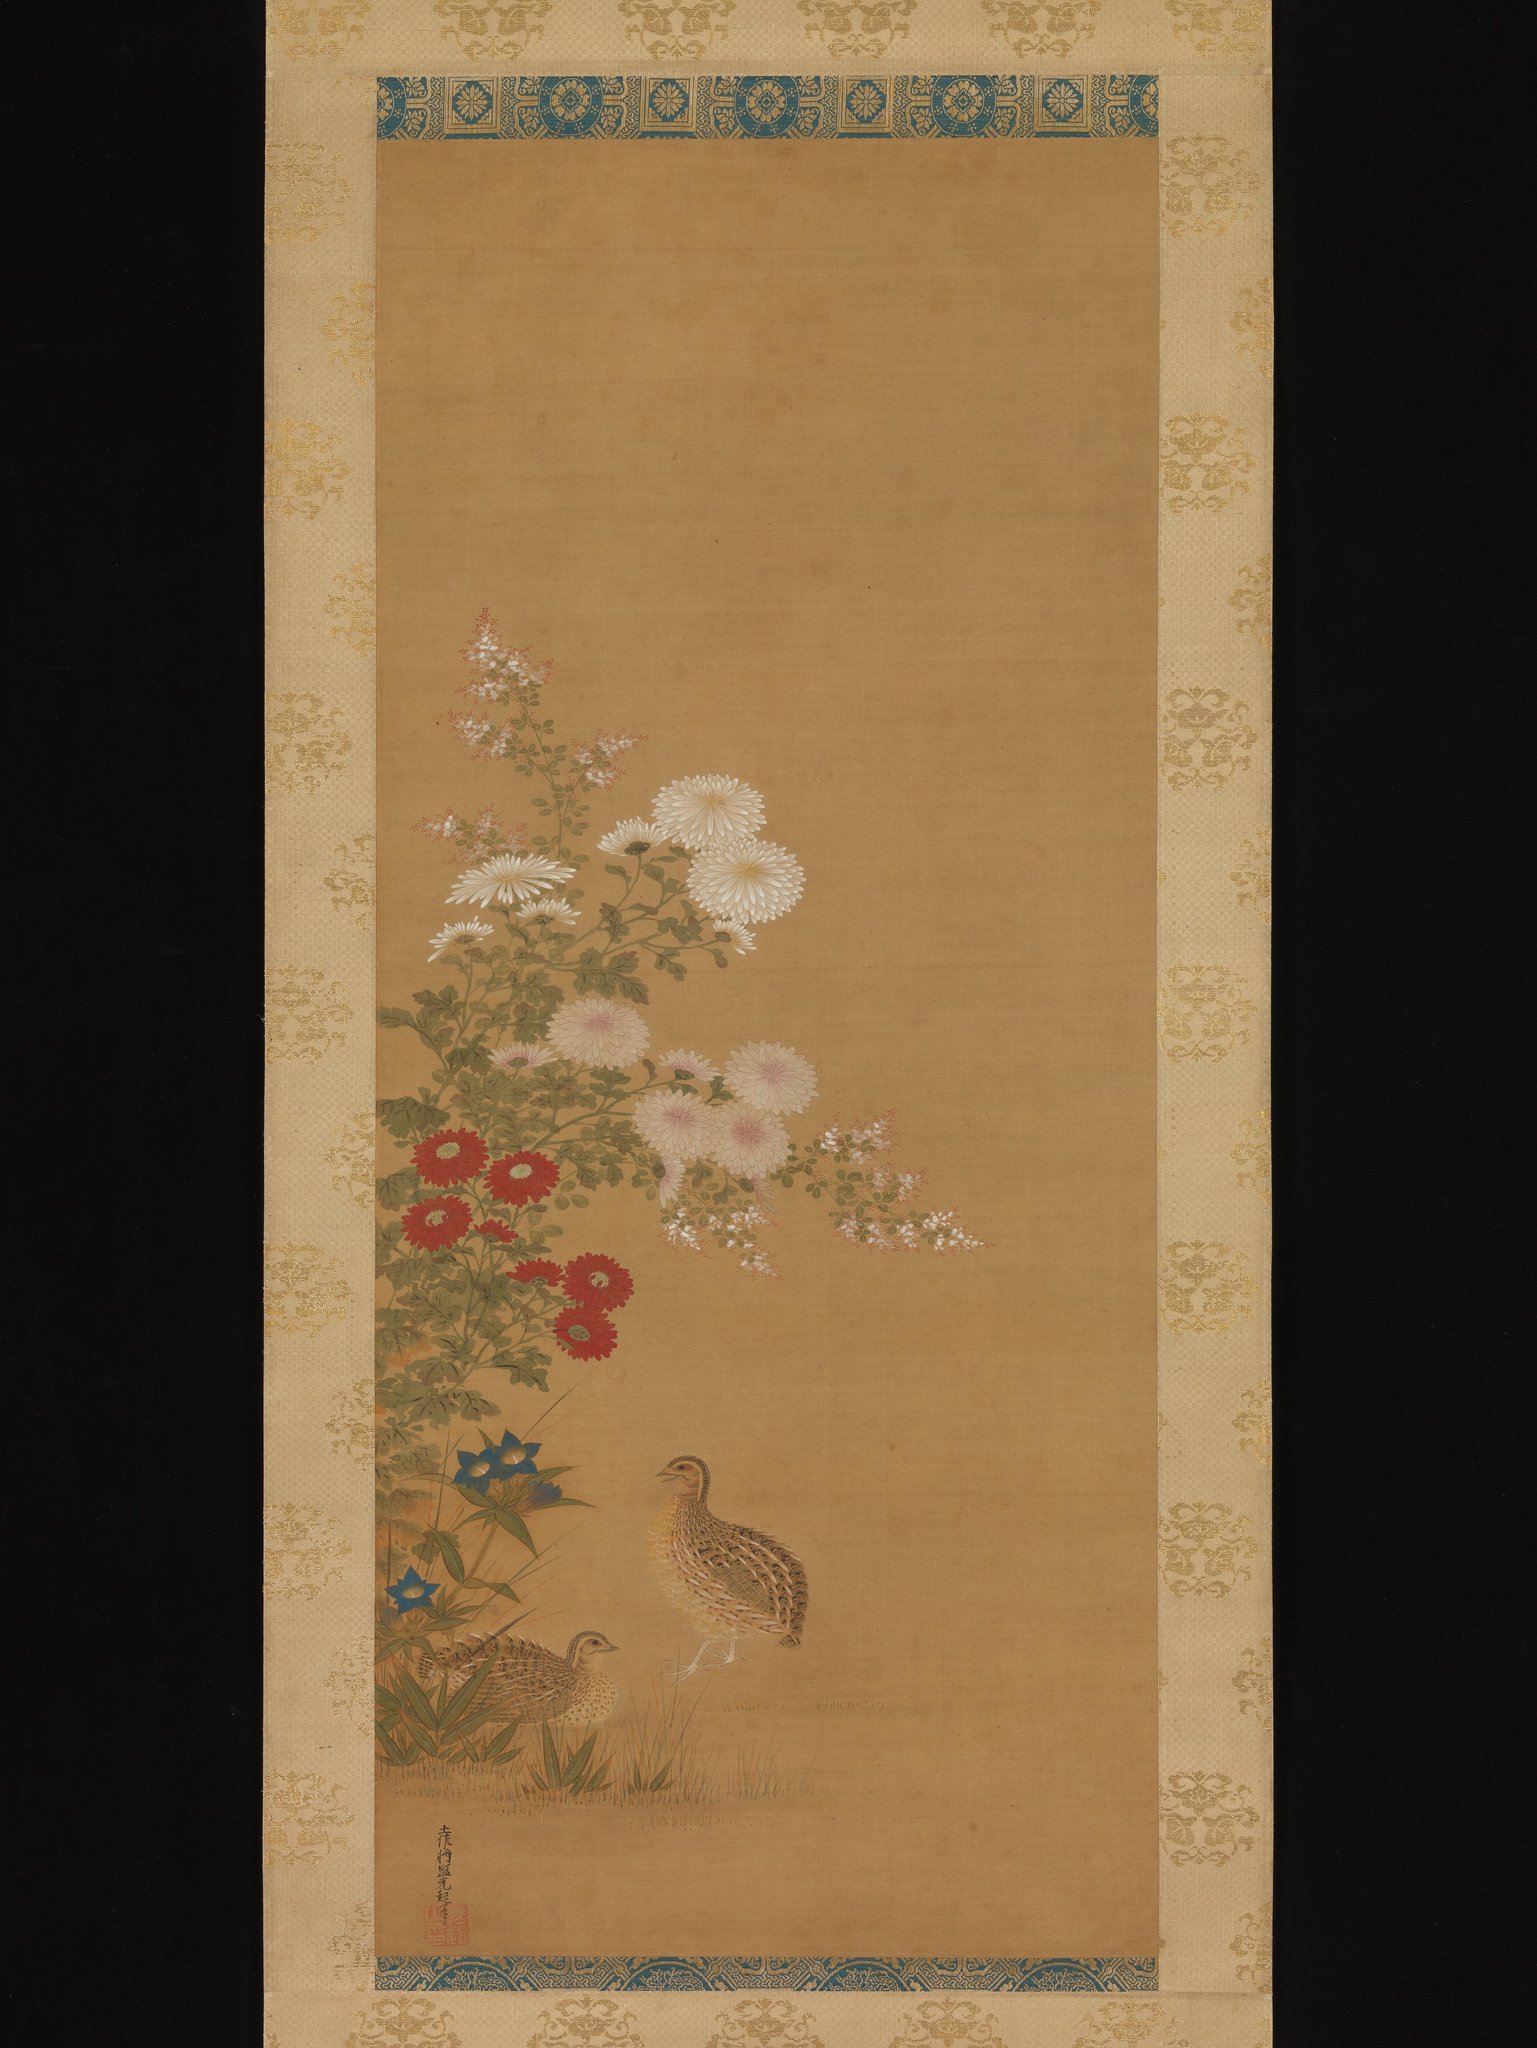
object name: hanging scroll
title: Quail and Autumn Flowers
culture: japanese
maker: tosa mitsuoki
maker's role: artist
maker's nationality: japanese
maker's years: 1617-1691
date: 1667-1700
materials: ink, silk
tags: birds,flowers